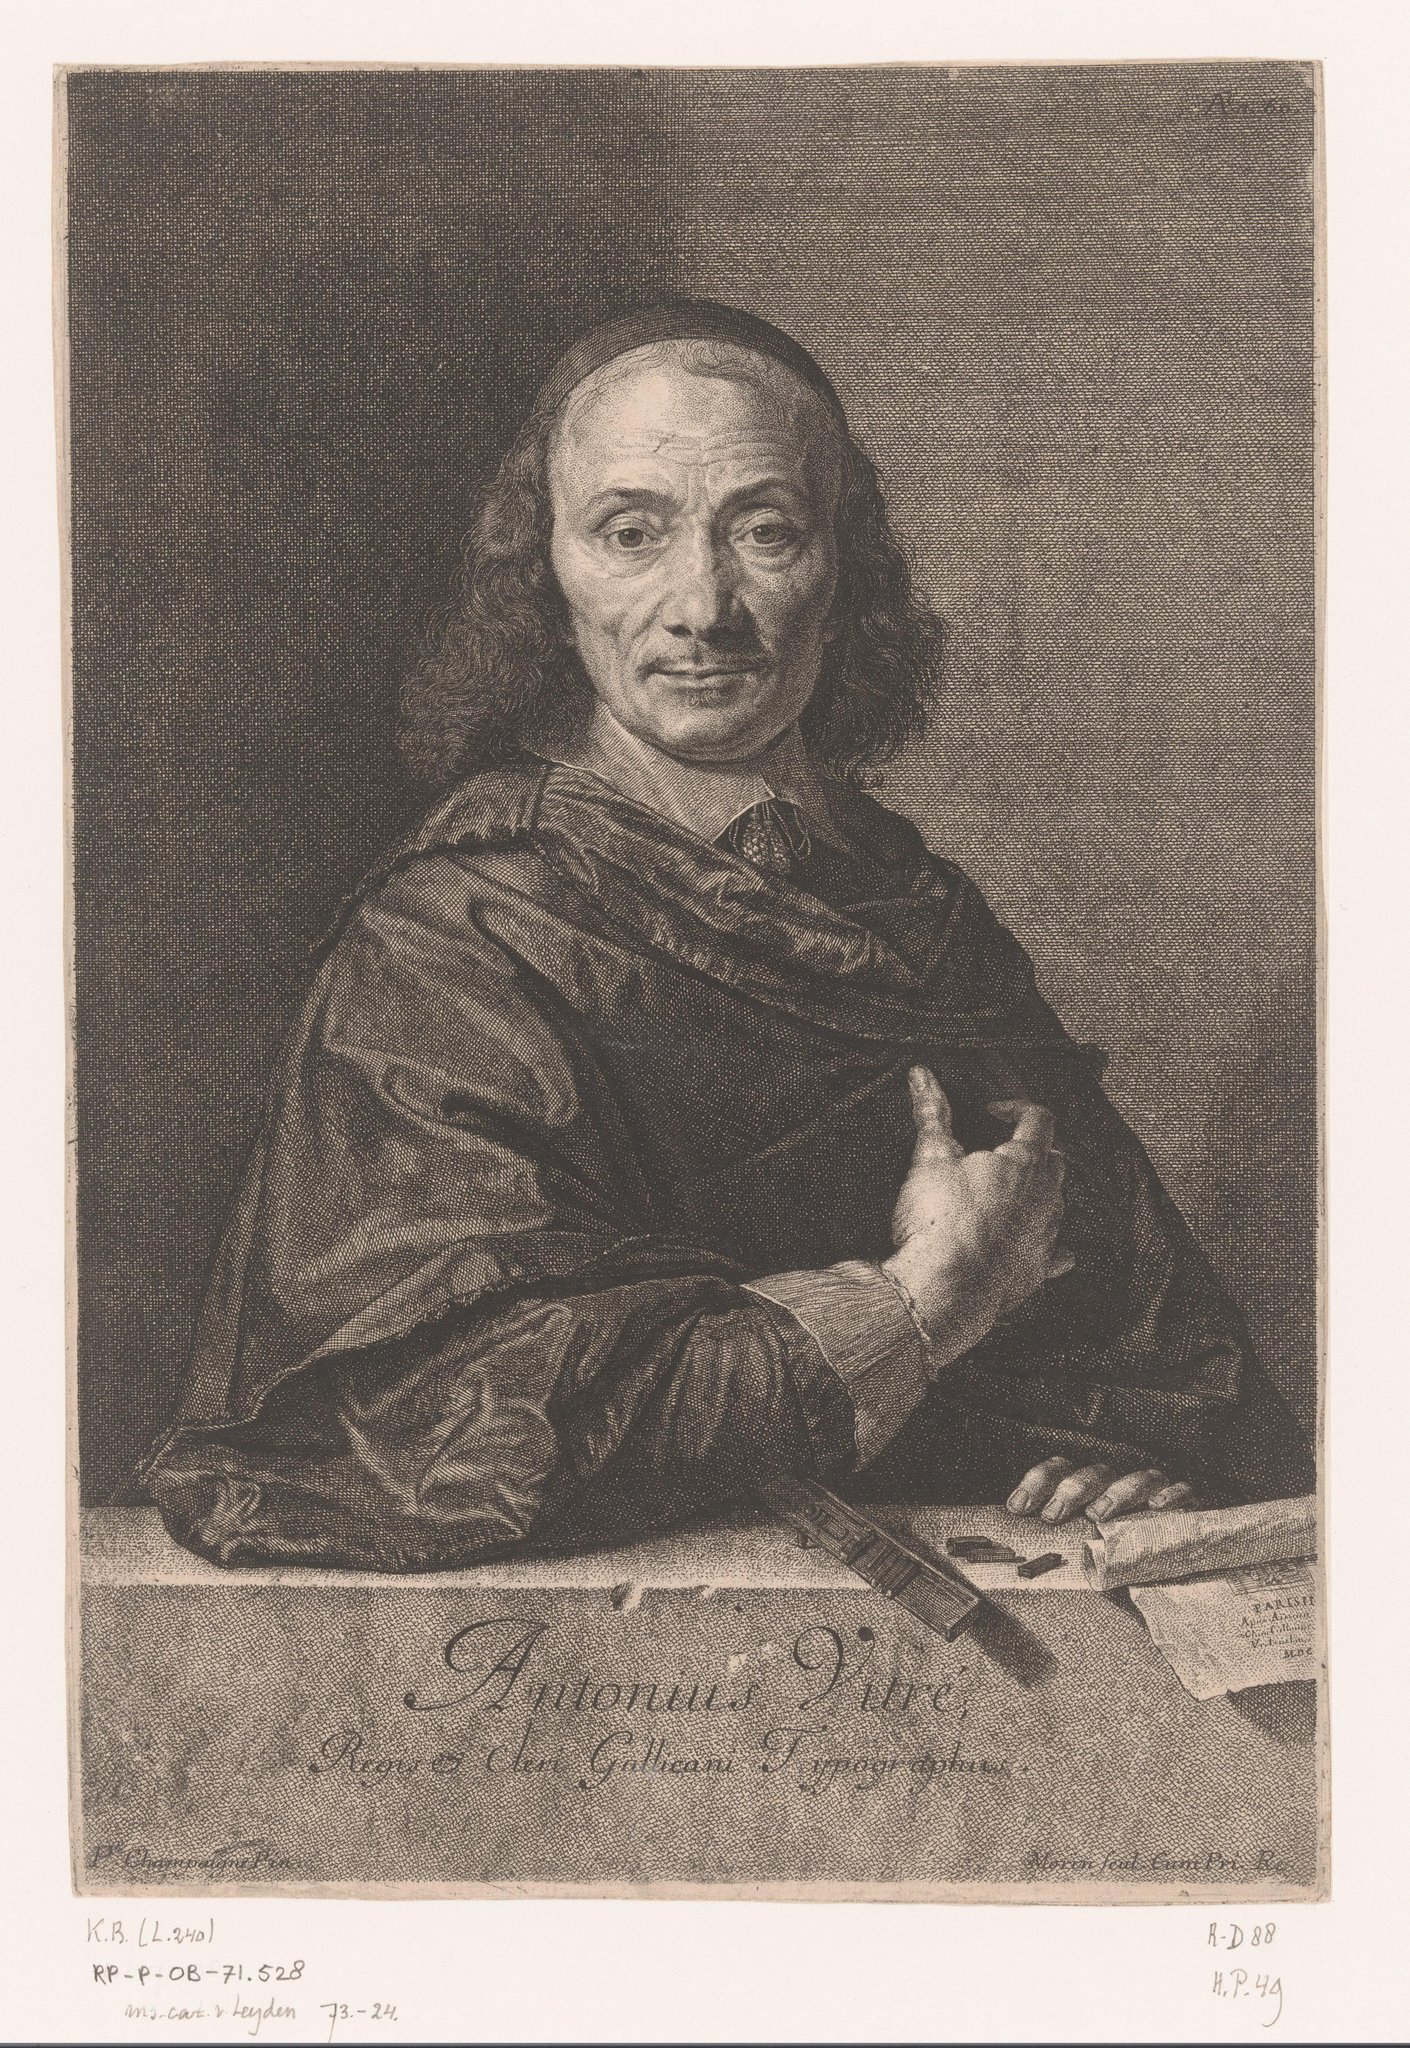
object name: print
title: Portret van Antoine Vitré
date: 1640-1650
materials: paper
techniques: etching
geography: france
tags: publisher, antoine vitré, historical persons, publishing, publisher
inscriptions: collector's mark: Lugt 240, number: ‘73.-24.’